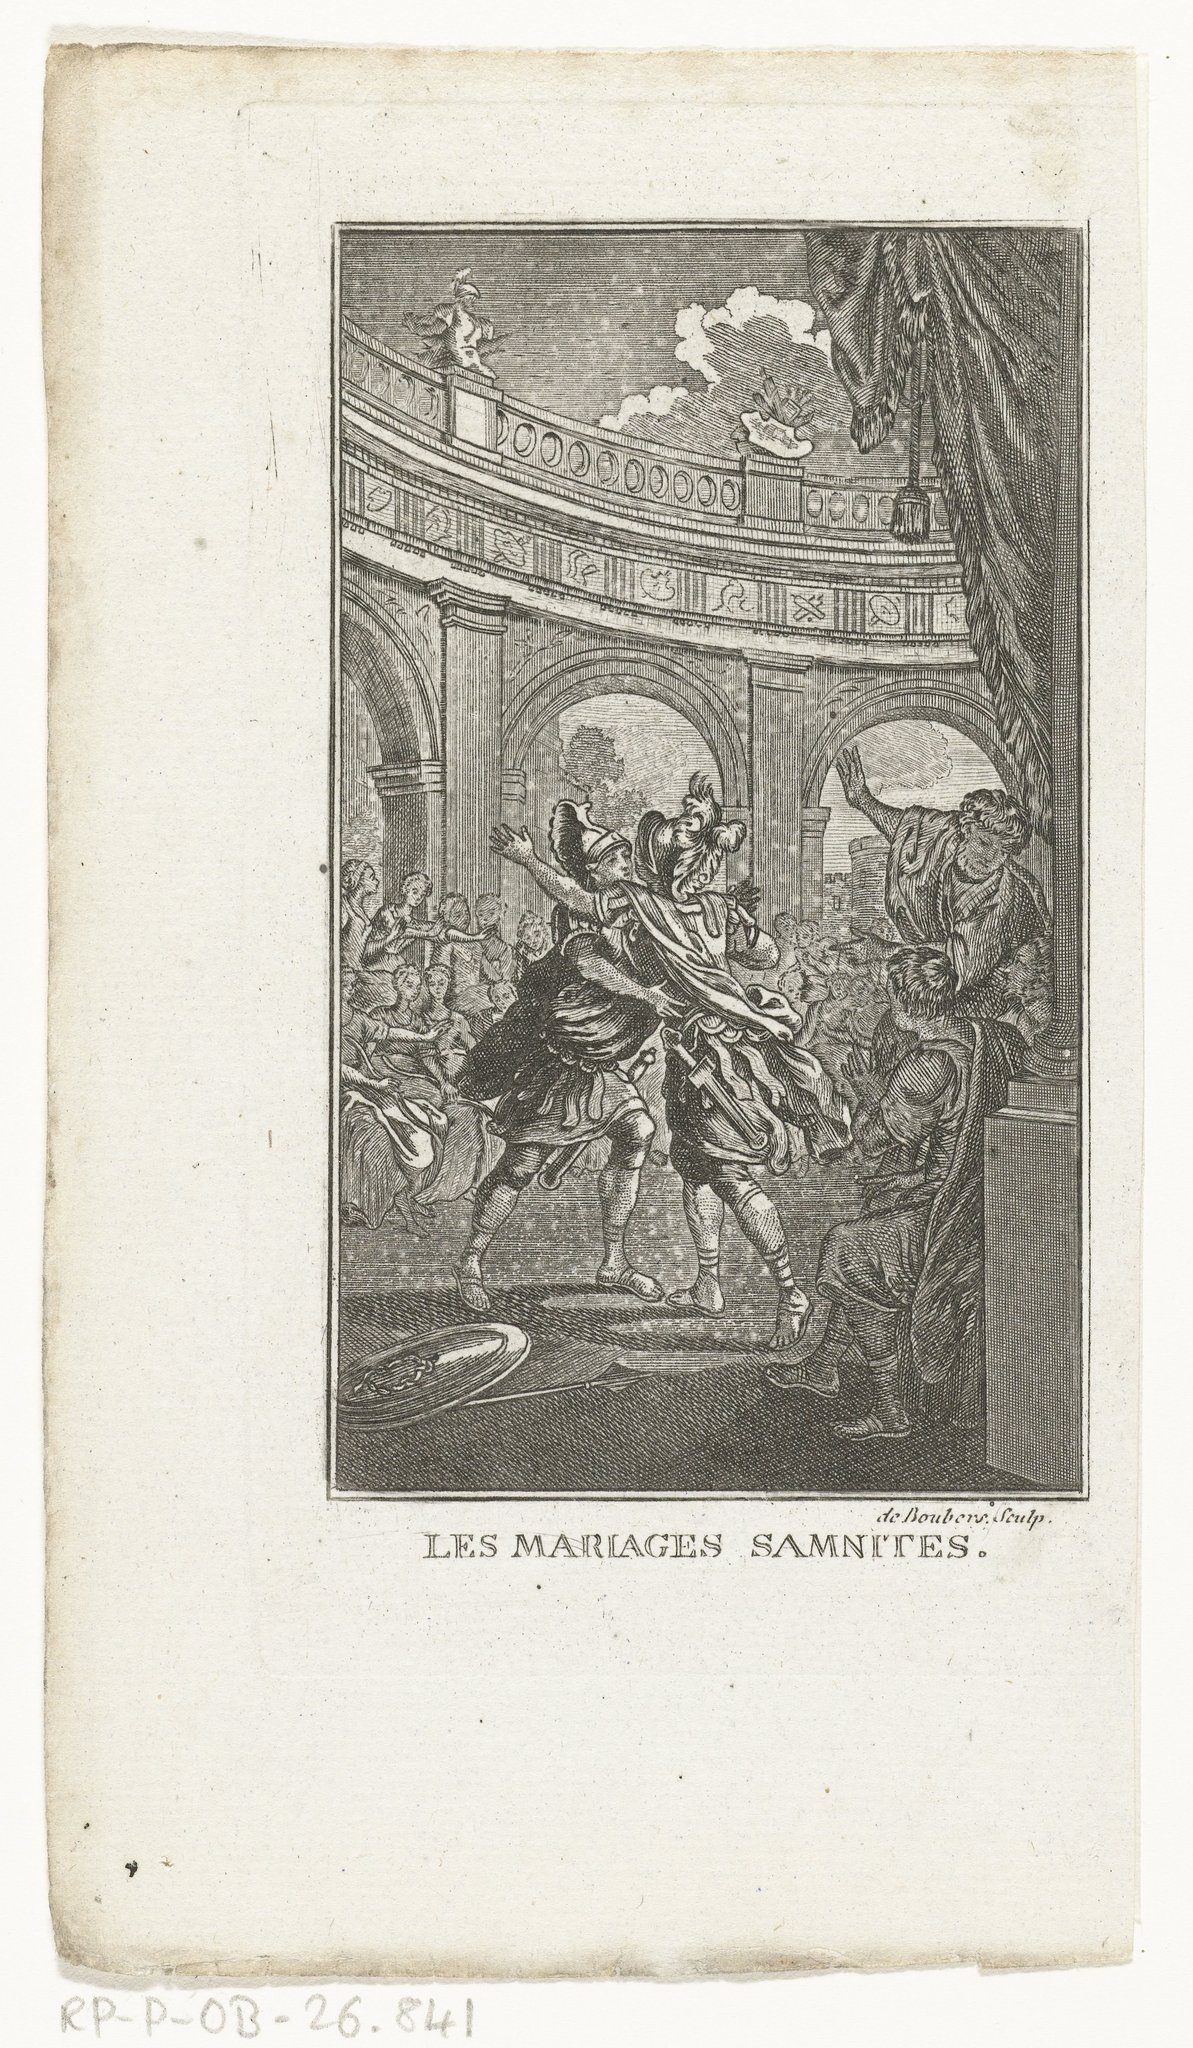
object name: print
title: Huwelijkspraktijken bij de Samniten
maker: n. de boubers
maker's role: print maker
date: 1765-1780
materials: paper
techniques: engraving, etching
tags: the (difficult) choice ~ courting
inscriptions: collector's mark: Lugt 2228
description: Illustratie voor het verhaal 'Les Mariages Samnites' uit J.F. Marmontel's verhalenbundel 'Contes moreaux'. Een keer per jaar kwamen bij de Samniten, een Italiaanse volksstam, alle jonge mannen en vrouwen bij elkaar op een groot plein. Hier werden vervolgens de huwelijkspartners uitgekozen. Twee jonge Samnitische soldaten omhelzen elkaar.